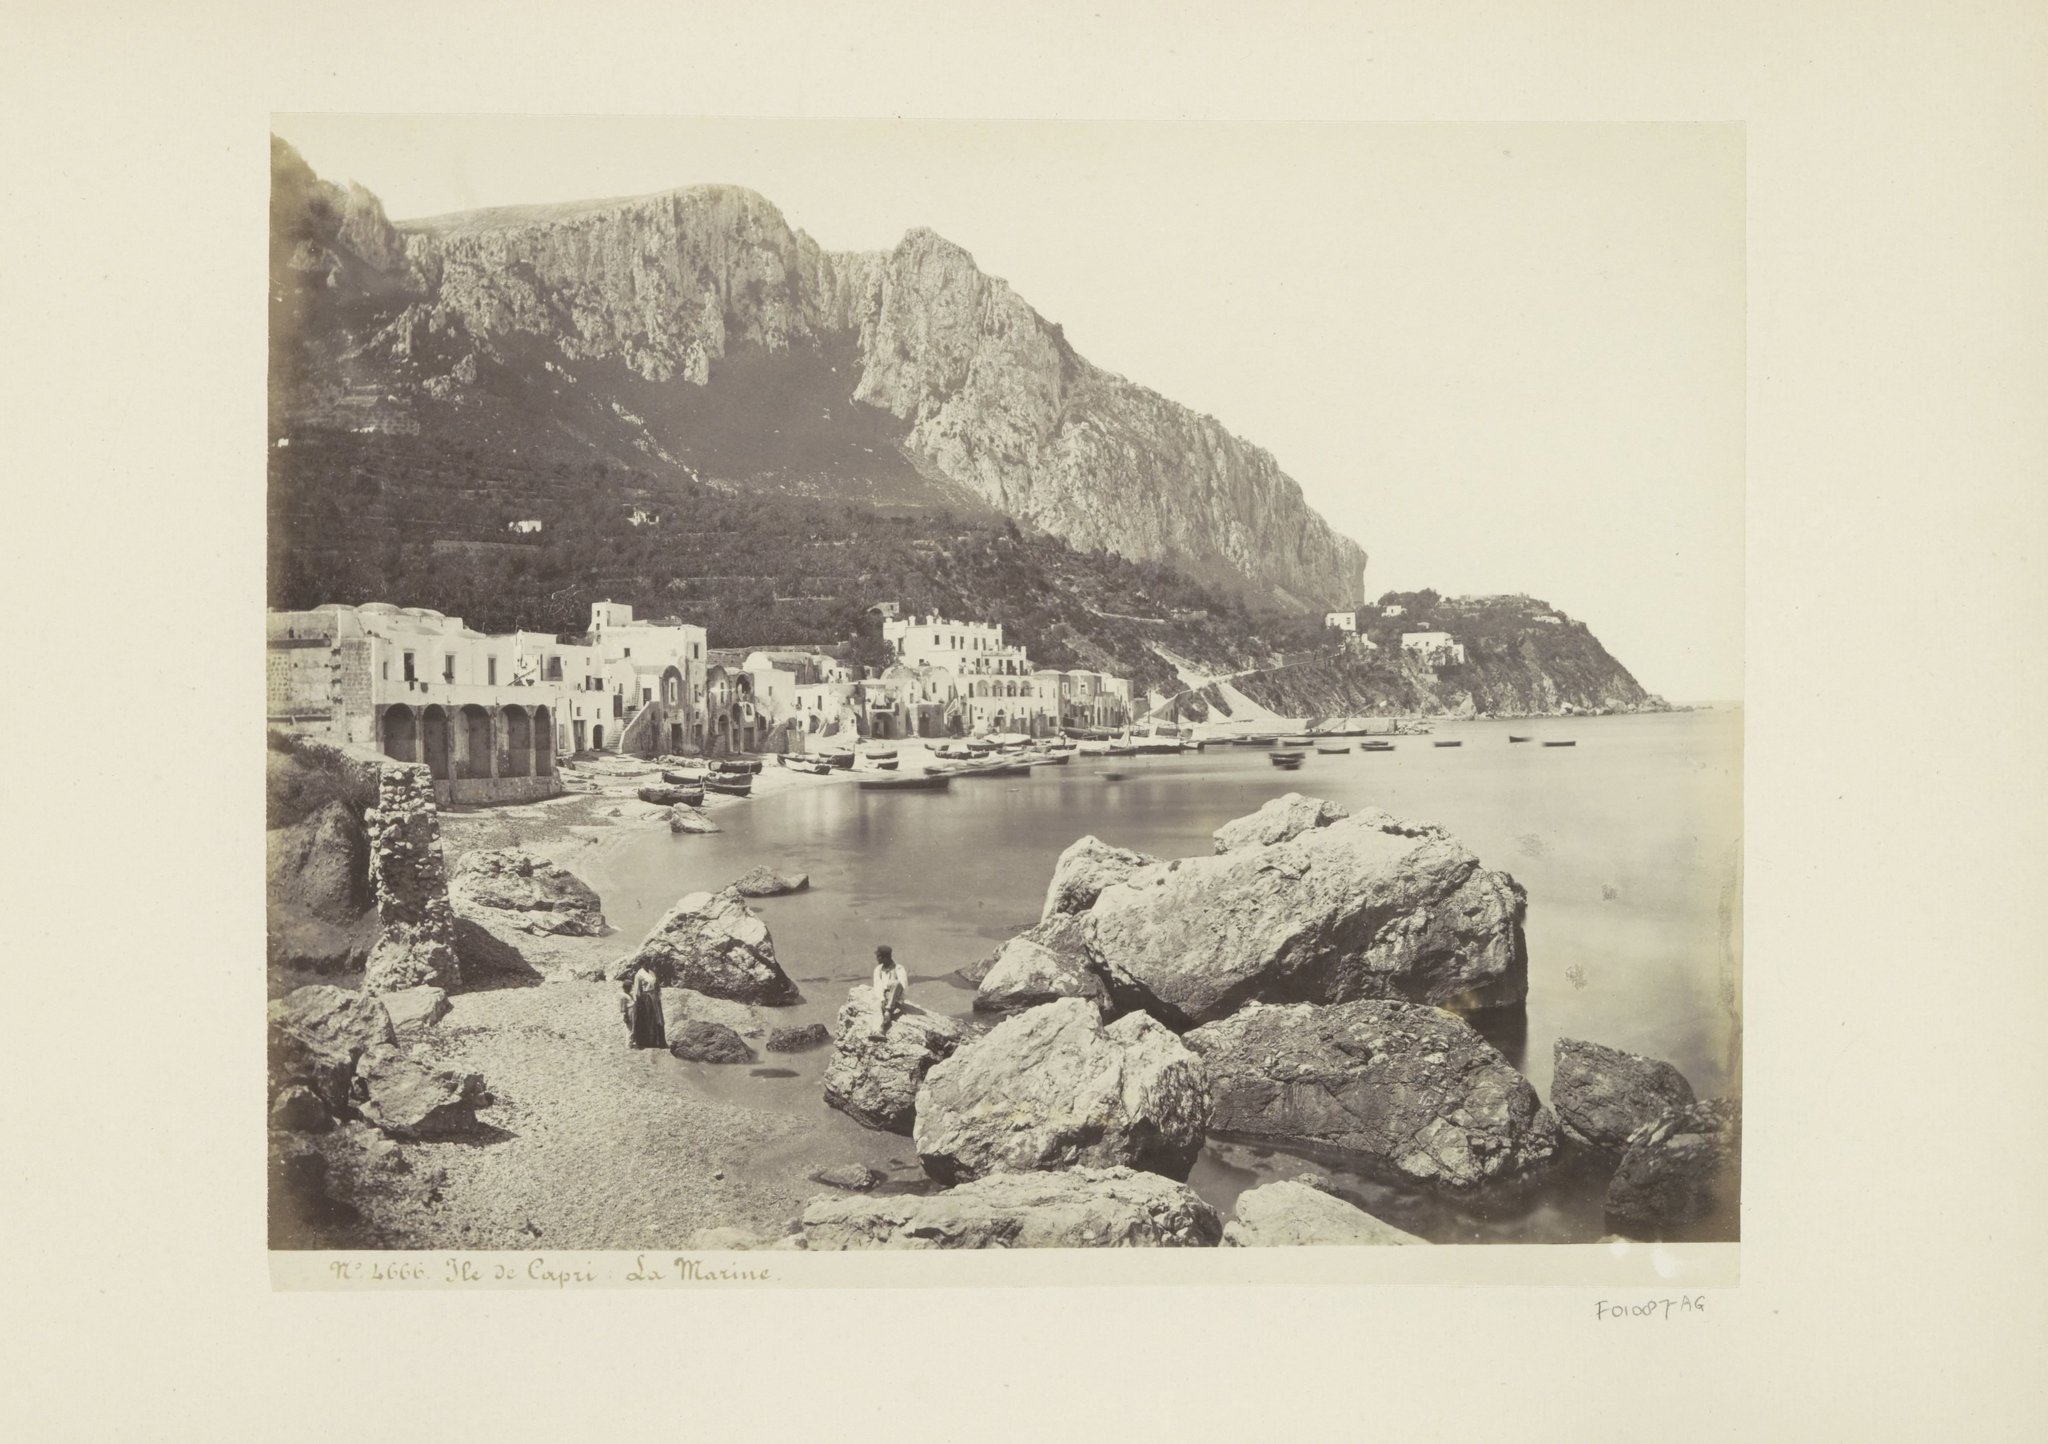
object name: photograph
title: Haven van Capri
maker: Anonymous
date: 1865-1875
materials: paper, photographic support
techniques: albumen print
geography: capri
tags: harbour (+ view ~ vehicle, ship, etc.), boulder, stone, capri, isola di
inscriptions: negative number: ‘4666’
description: Onderdeel van Reisalbum met foto's van bezienswaardigheden in Napels en omgeving.